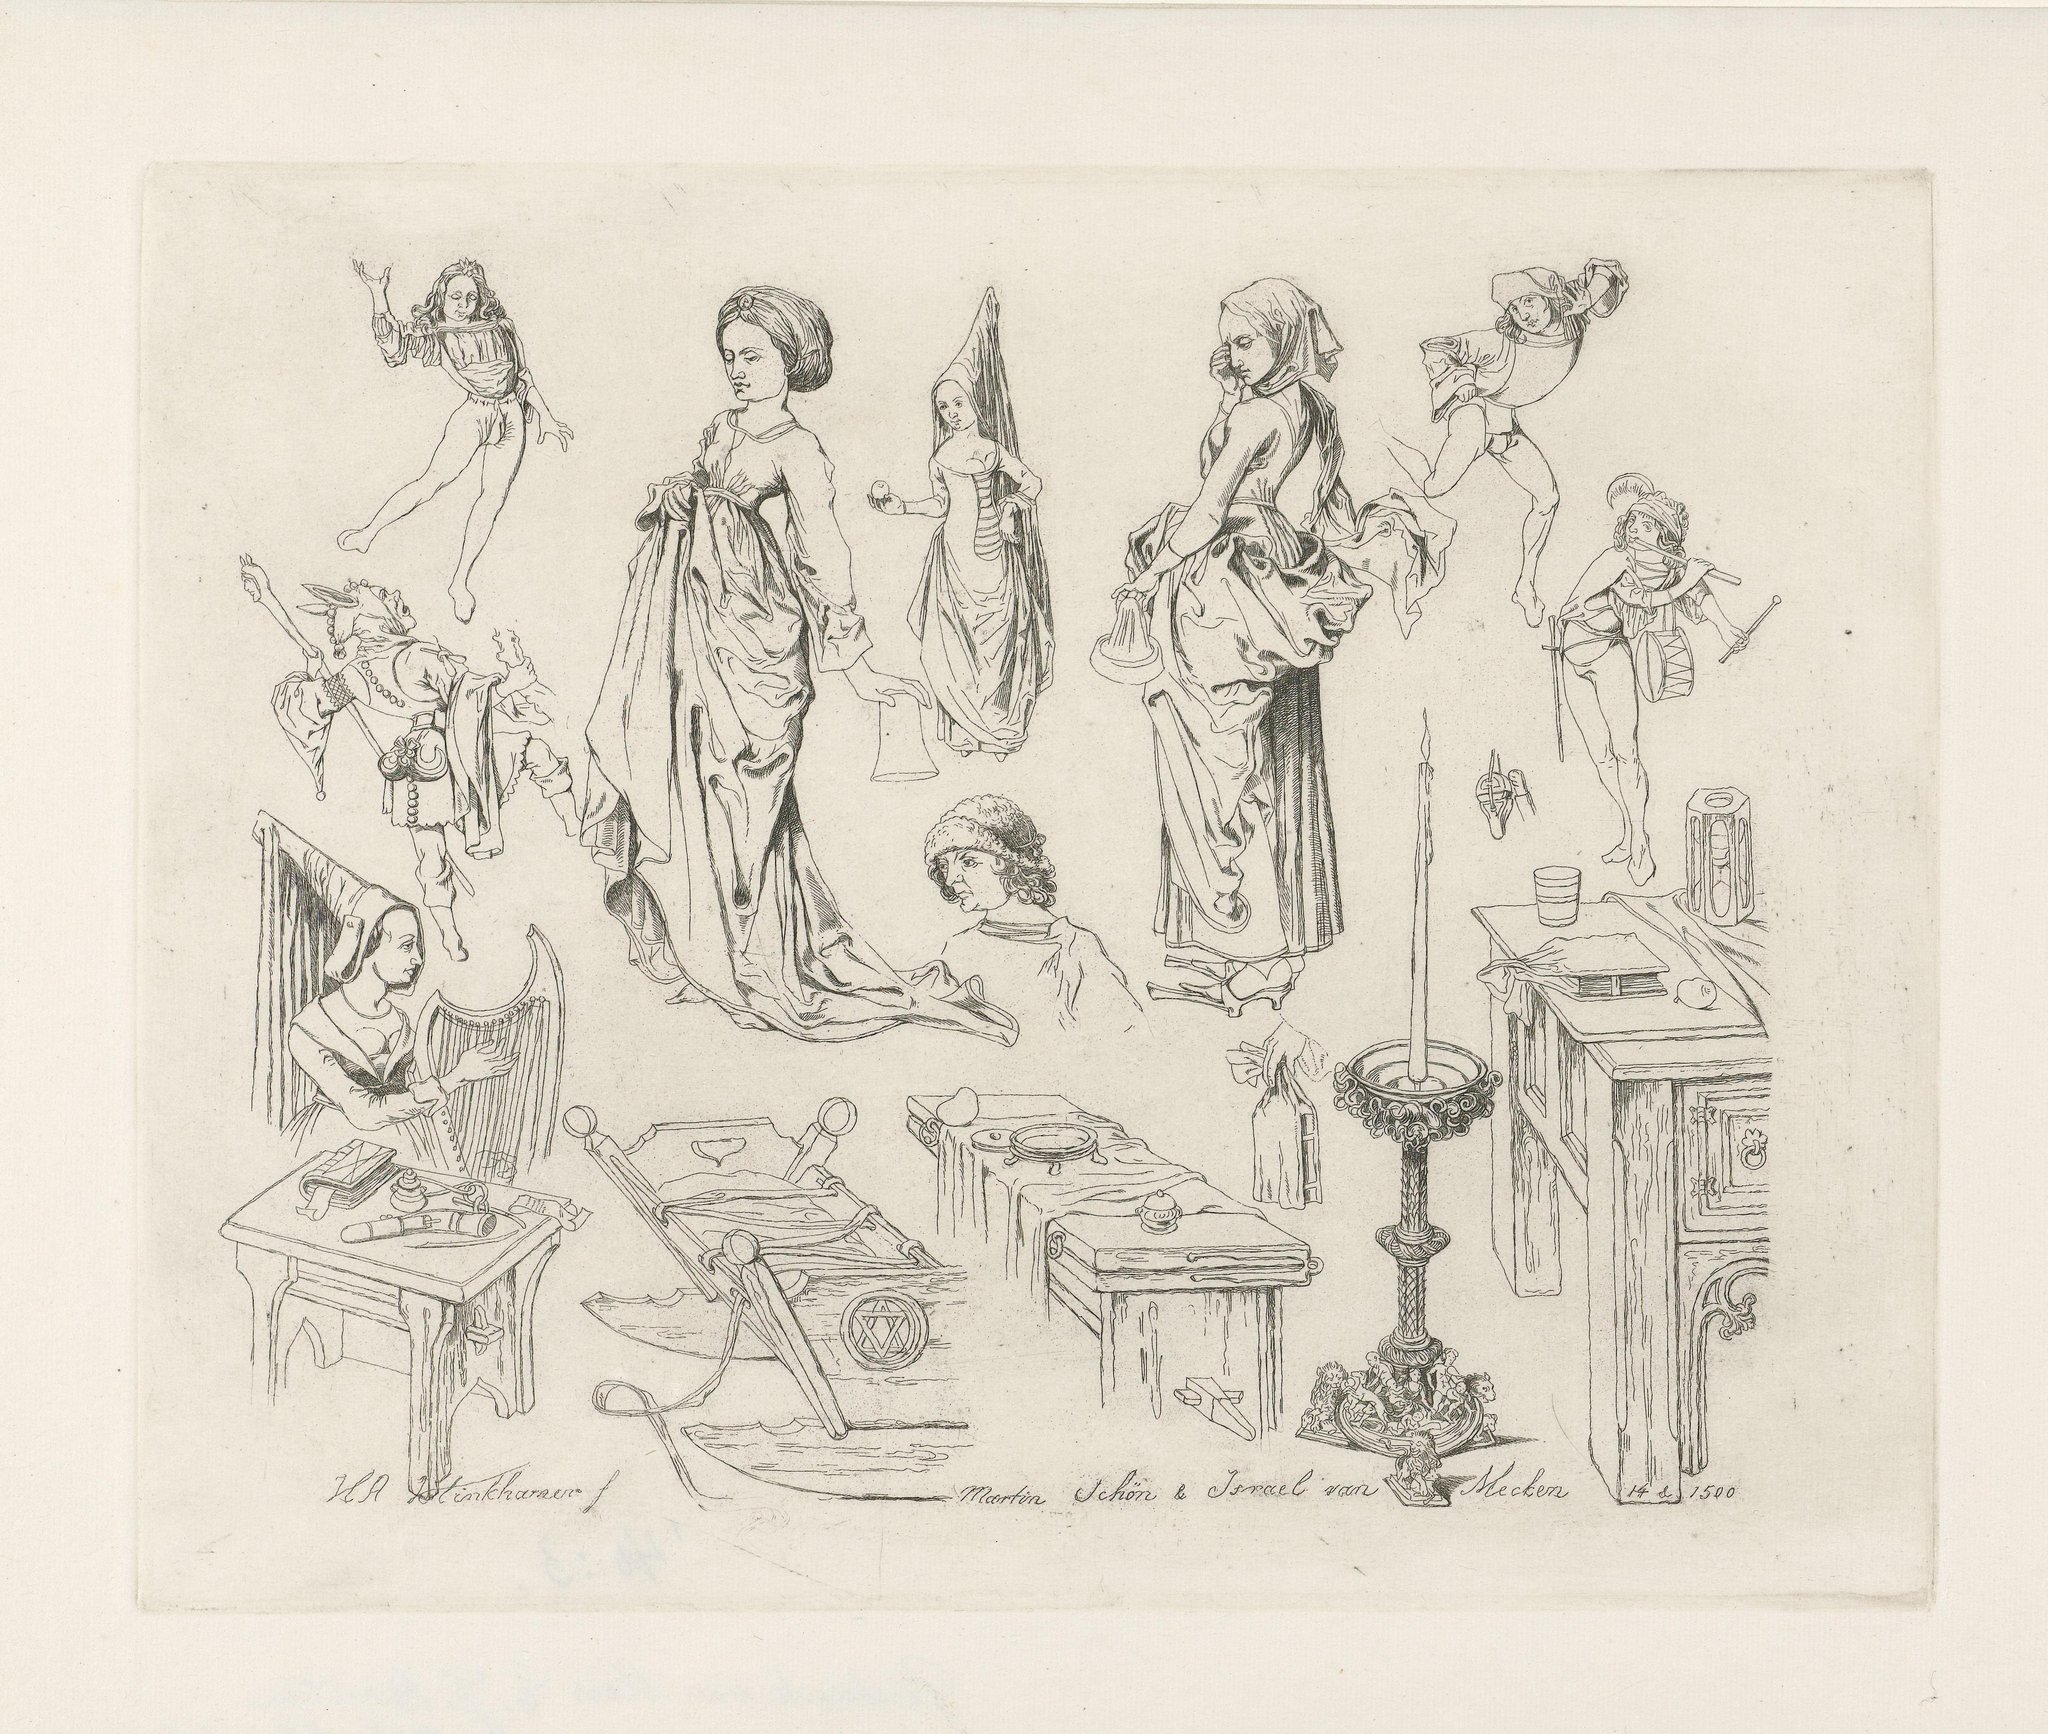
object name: print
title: Studieblad met dansende en musicerende figuren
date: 1820-1872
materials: paper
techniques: etching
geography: amsterdam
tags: court jester, court fool, drum (musical instrument), harp, man dancing alone, attributes of court jester, candlestick, flute, aulos, tibia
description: Studieblad met dansende en musicerende figuren in Middeleeuwse kleding. Links een dansende nar met marot en rechts een man die tegelijk een fluit en een trom bespeelt. In het midden een dame met een punthoed op het hoofd en een appel in haar rechterhand. Onder een vrouw die een harp bespeelt en een puntmuts draagt. Naast haar een aantal Middeleeuwse meubels, waaronder een wieg en een gedecoreerde kaarsenstandaard.